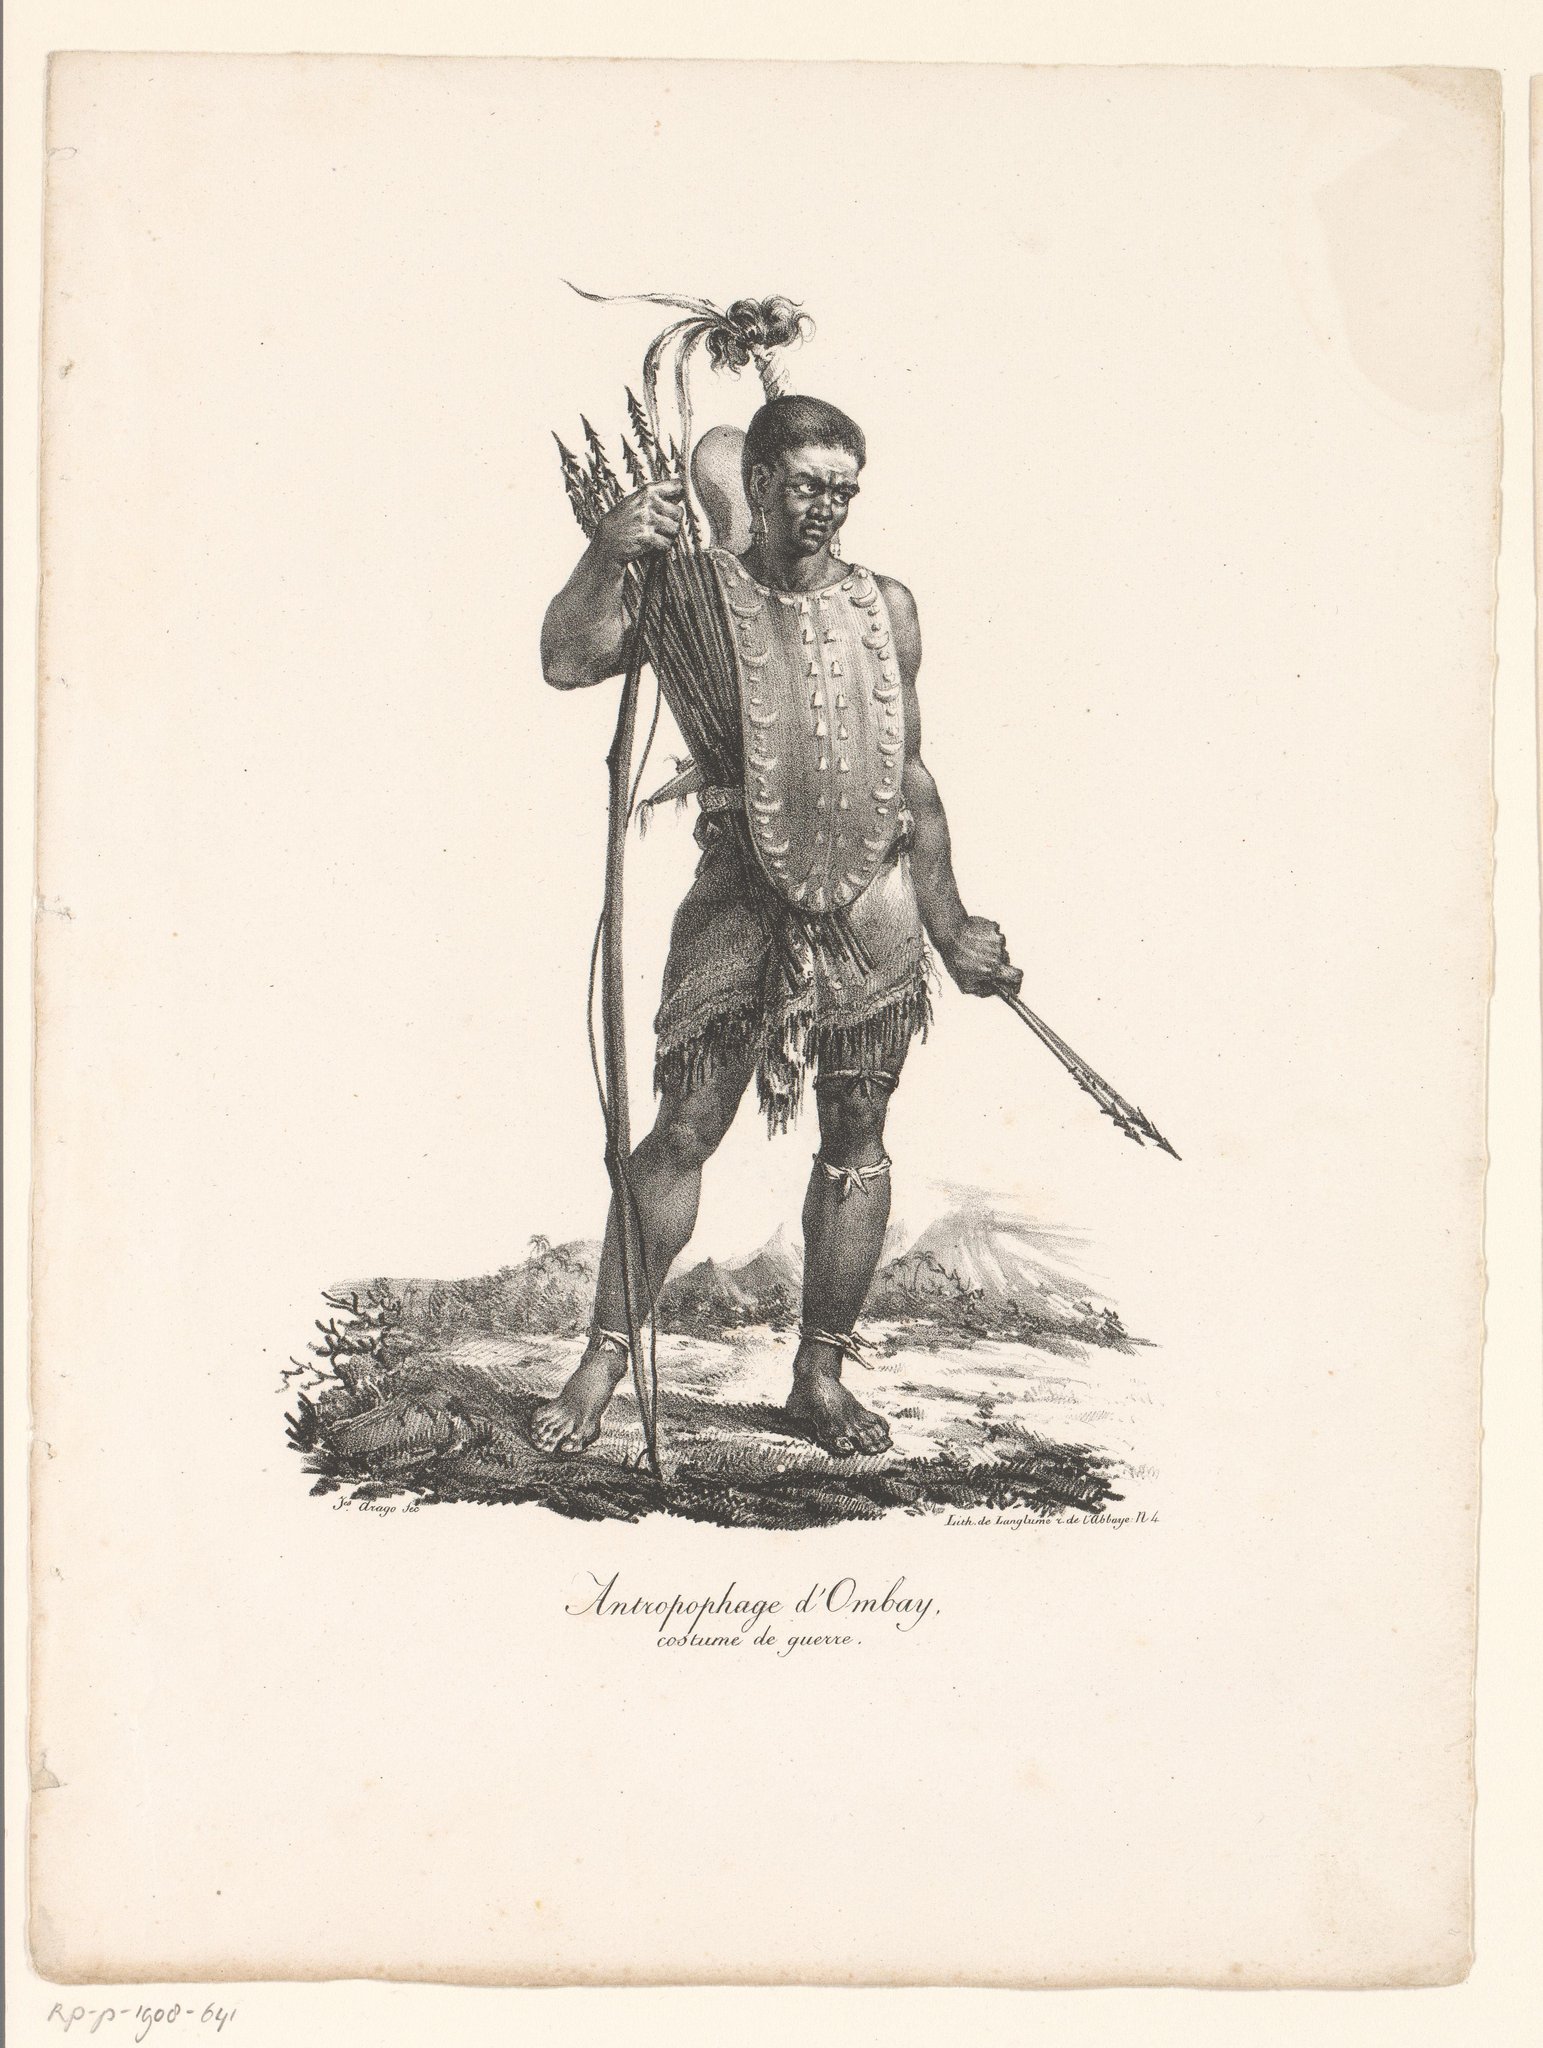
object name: book illustration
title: Promenade autour du monde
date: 1822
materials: paper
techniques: lithograph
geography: paris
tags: asiatic races and peoples, archer's weapons: bow and arrow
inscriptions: collector's mark: Lugt 2228a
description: Prent mogelijk uit een album dat is uitgegeven bij: Arago, J.E.V. Promenade autour de monde pendant les années 1817, 1818, 1819 et 1820, sur les corvettes du roi l'Uranie et la Physicienne, commandées par M. Freycinet. 2 dln. Parijs: Leblanc, 1822.